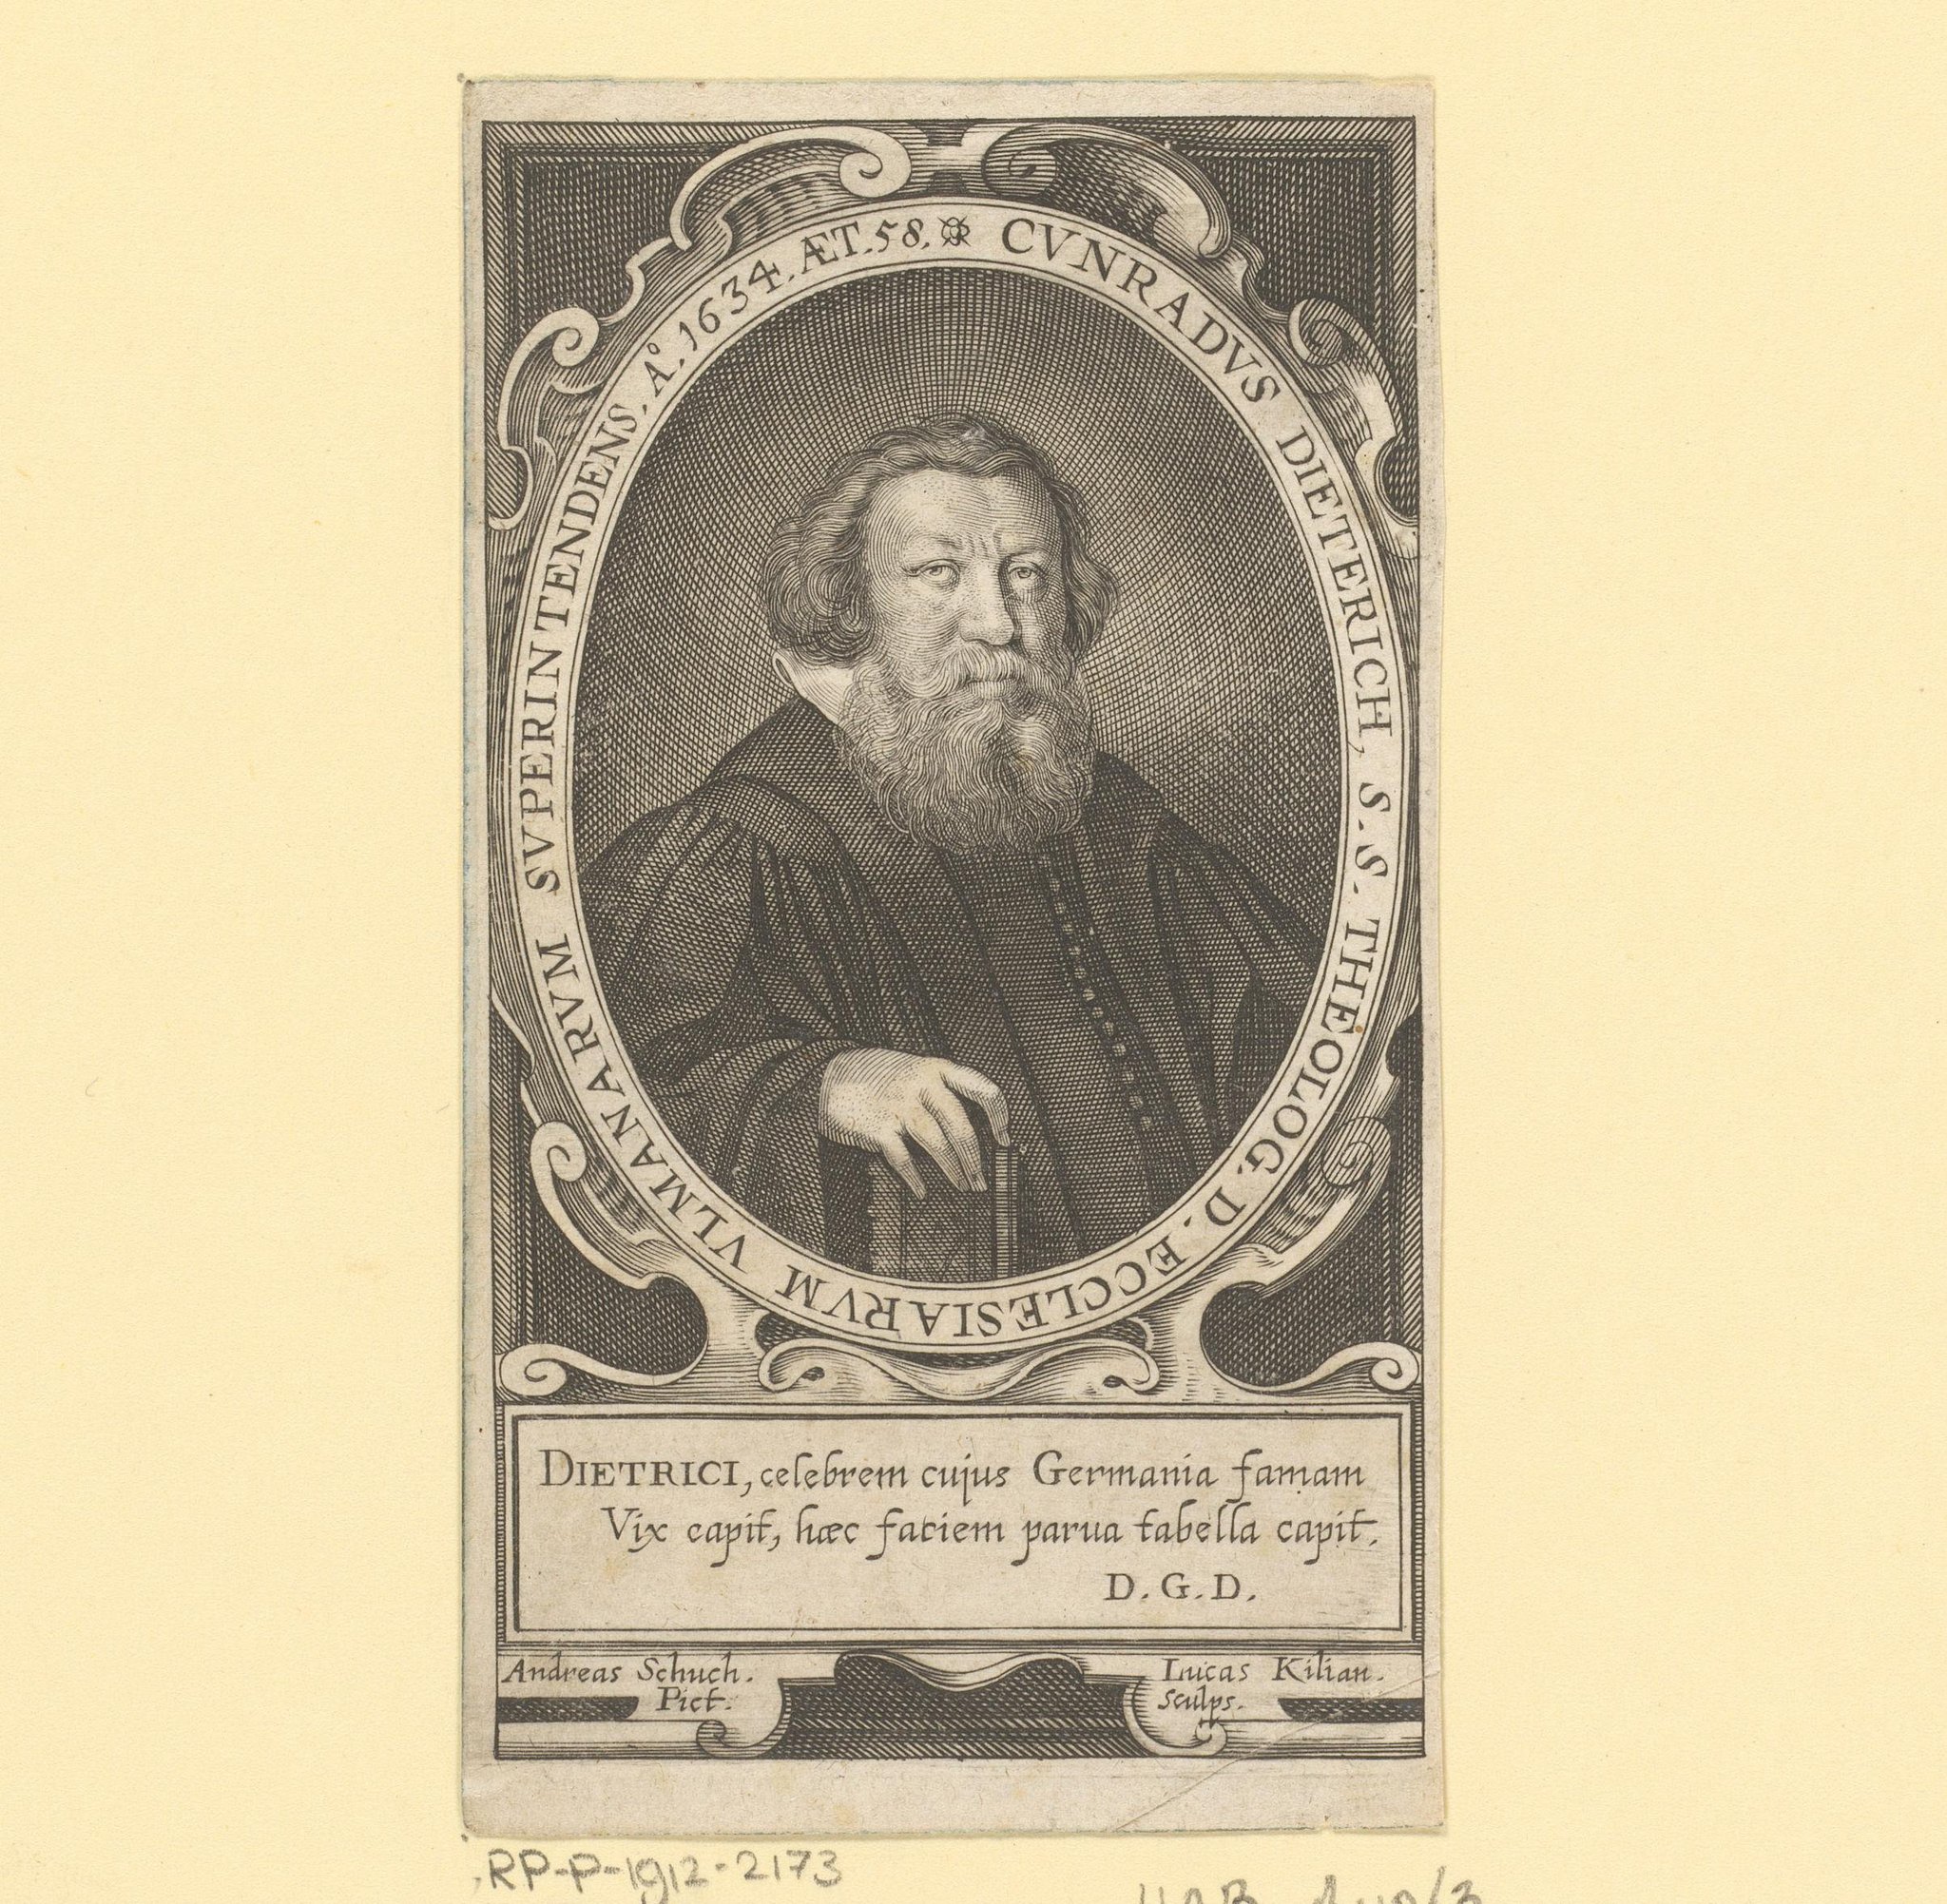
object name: print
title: Portret van Konrad Dieterich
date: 1634-1637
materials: paper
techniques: engraving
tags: historical persons, book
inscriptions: collector's mark: Lugt 2228